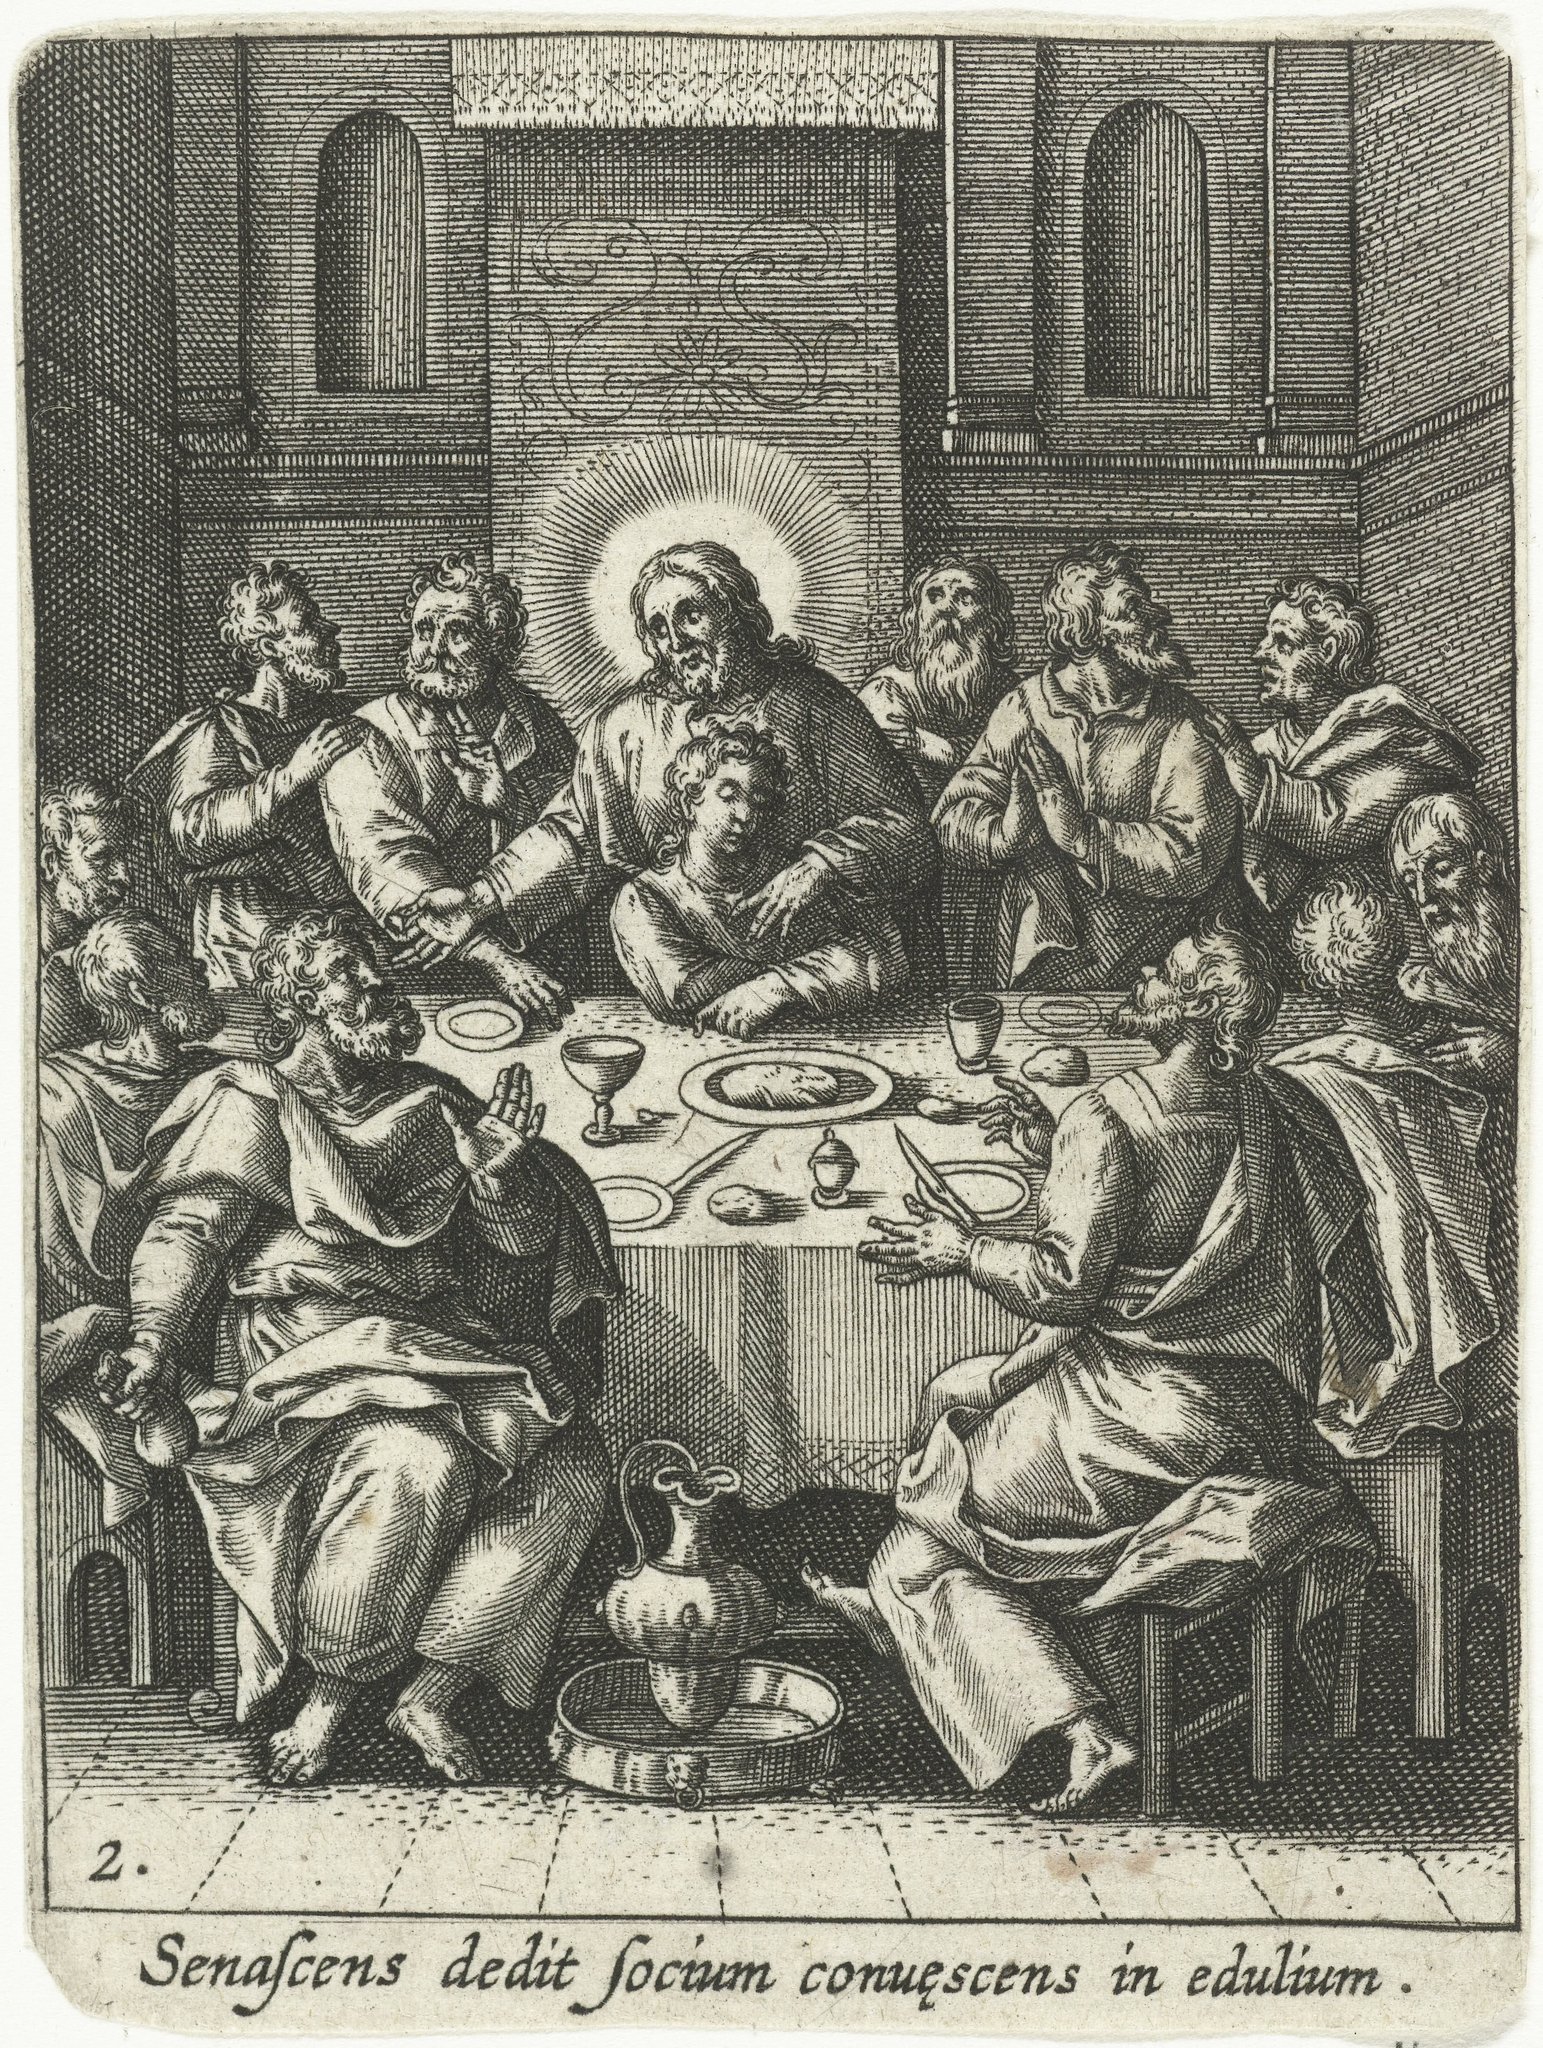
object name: print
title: Laatste avondmaal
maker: adriaen collaert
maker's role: draughtsman, print maker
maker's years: 1560-1618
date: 1570-1618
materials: paper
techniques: engraving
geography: antwerp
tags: last supper (in general) (matthew 26:21-35; mark 14:18-31; luke 22:3, 22:15-23; john 13:21-38)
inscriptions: collector's mark: Lugt 2228, collector's mark: Lugt 240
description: Christus en zijn apostelen zitten samen aan een tafel en delen brood en wijn. De prent heeft een Latijns onderschrift